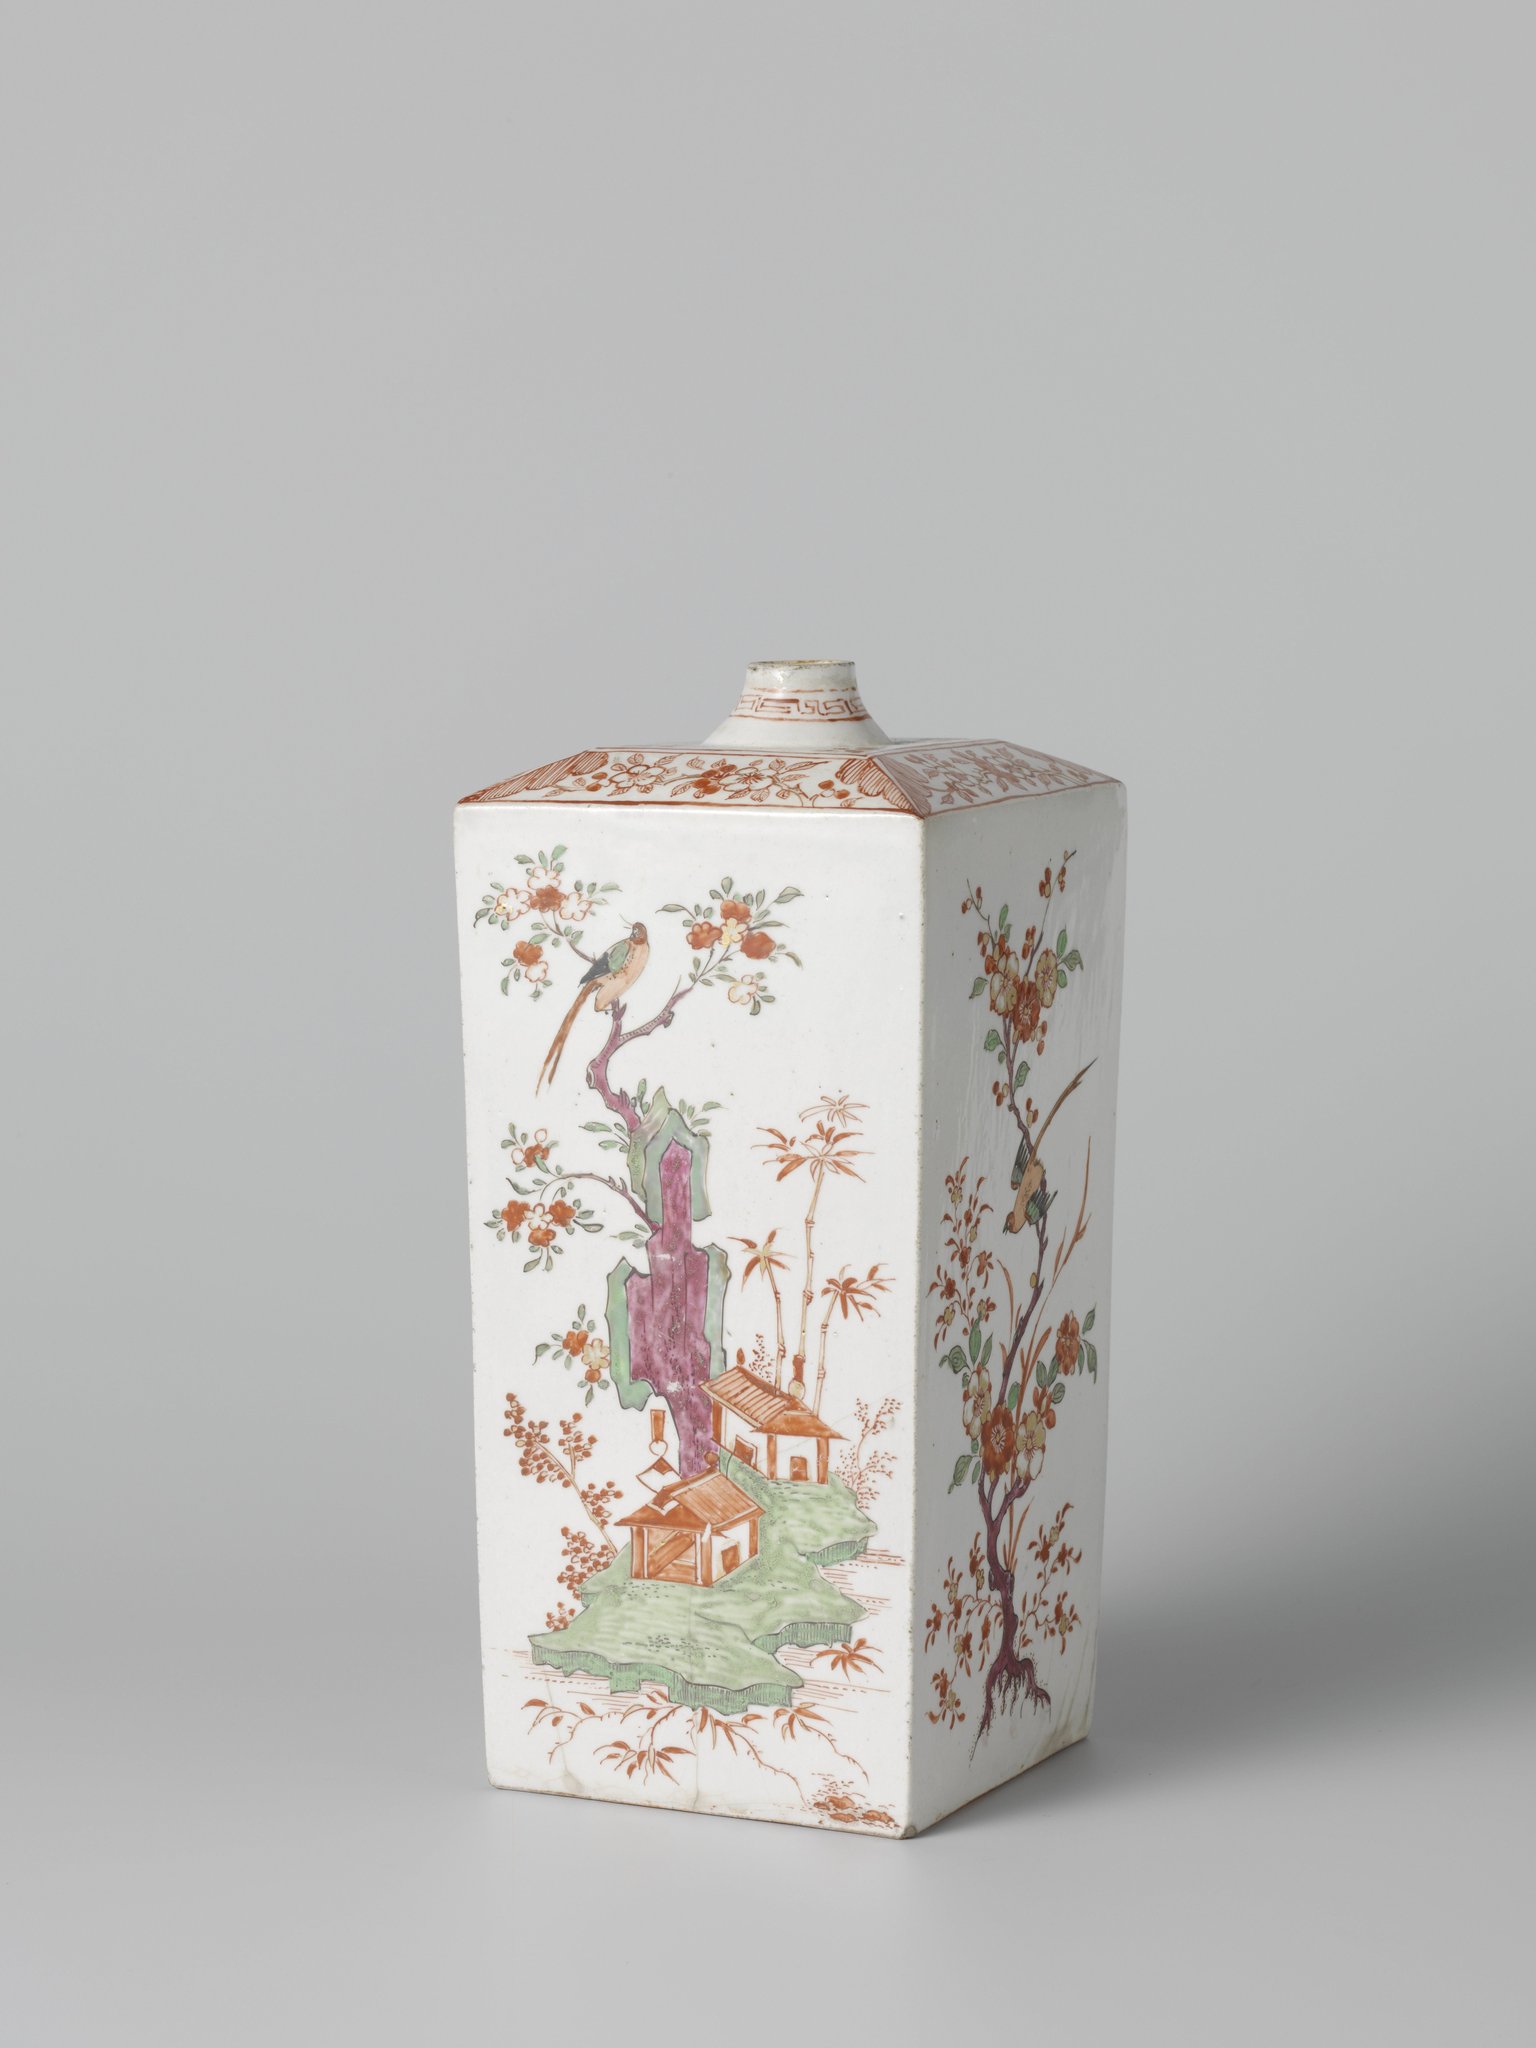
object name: bottle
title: Square bottle with birds, flowering plants and pavilions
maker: Anonymous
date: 1700-1724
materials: bronze, glaze, gold, paint, porcelain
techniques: firing, forming, gilding, vitrification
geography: europe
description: Vierkante fles van porselein met een verguld, bronzen dop, beschilderd op het glazuur in rood, groen, geel, paars, zwart en goud. Op de wanden tweemaal paviljoens op een eiland met rotsen en bloeiende planten (bamboe), een vogel op een tak, en tweemaal een vliegende vogel bij een prunustak en bamboe. Op de schouder een band met prunustakken en een bladmotief; rond de hals ranken. Op de hals een meanderpatroon. De dop is in de vorm van een zwaan met gespreide vleugels op een bloemrozet. De rand is afgeslepen. Een chip in de voet en enkele barsten. Arita, in Europa gedecoreerd [?] in de Japanse Kakiemon-stijl.